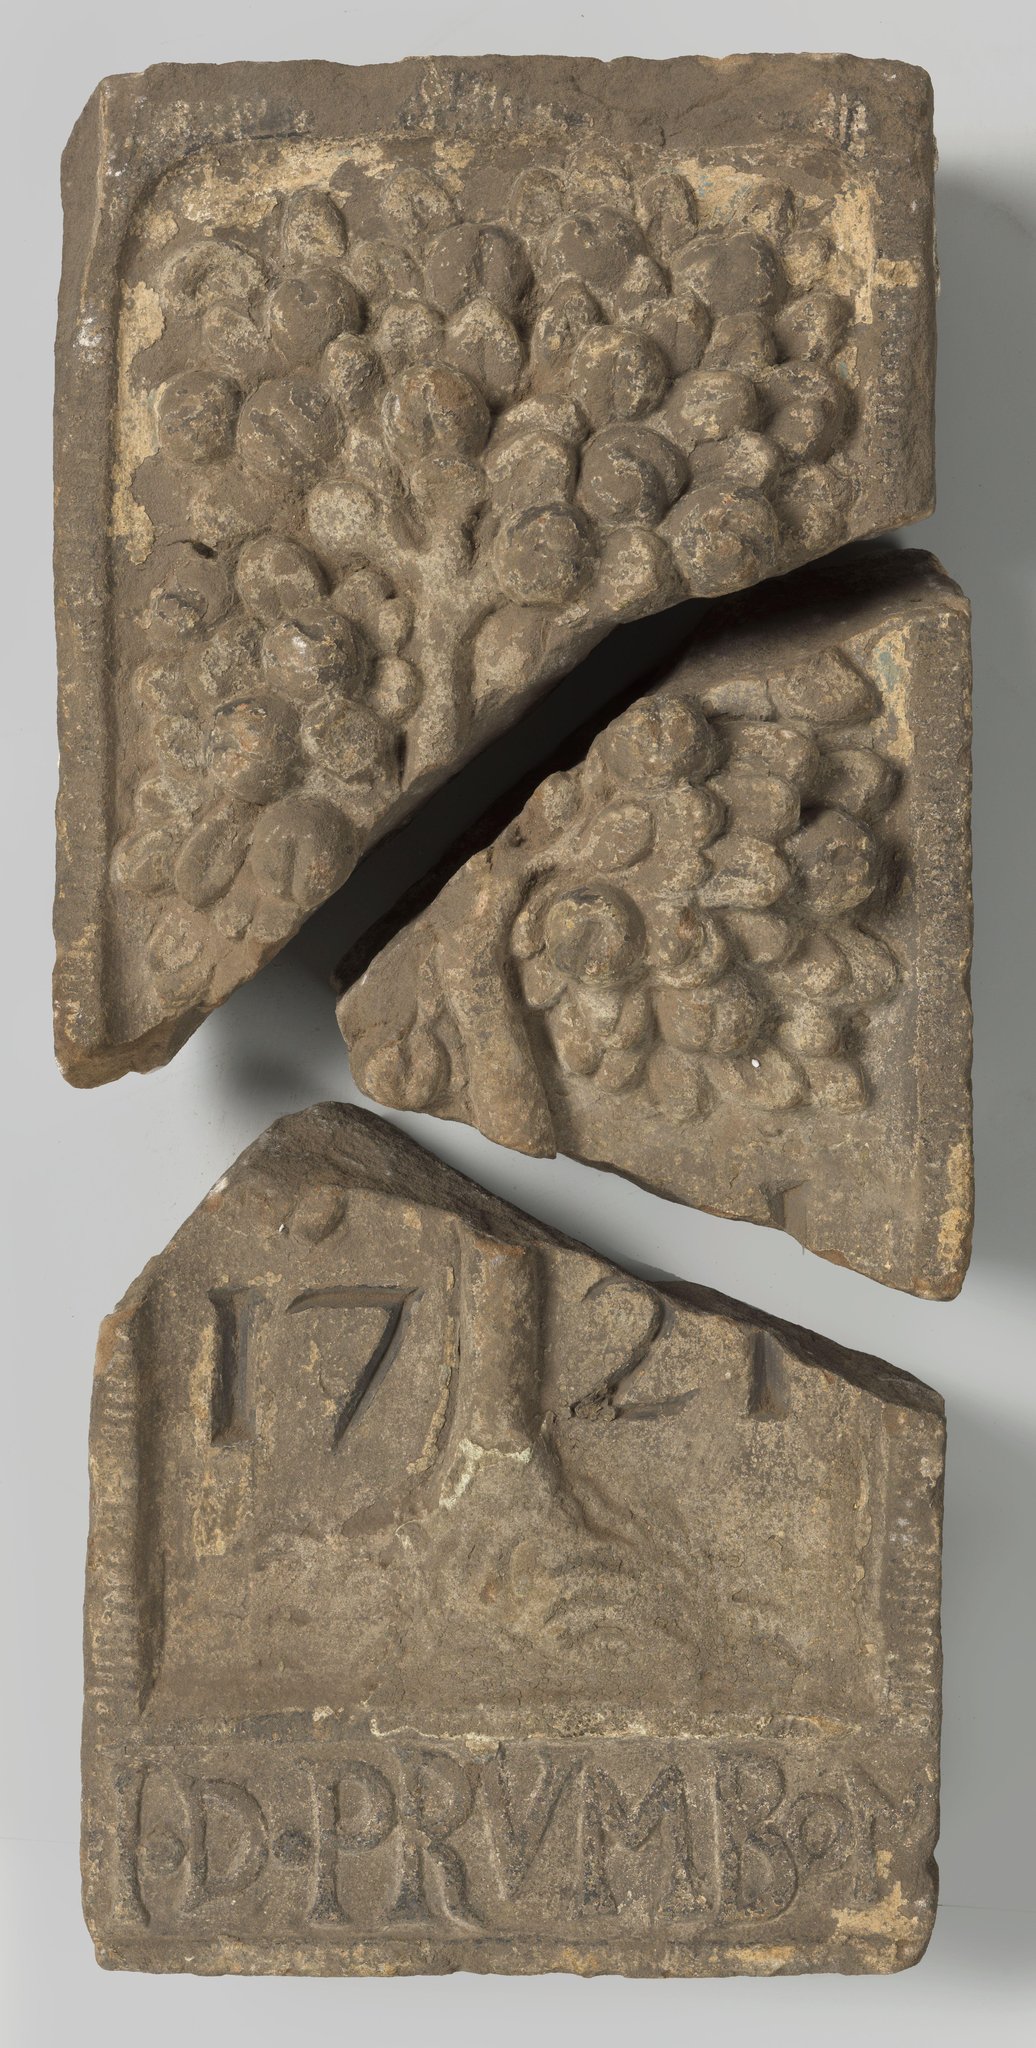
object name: gable stone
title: Gevelsteen met boom en opschrift: D.PRVMBOM.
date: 1721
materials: stone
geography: netherlands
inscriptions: date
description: Staande rechthoek met een boom met vruchten (pruimen). Links van de stam 17, rechts van de stam 21 en het onderschrift I.D. PRVMBOM. De gevelsteen is in drie stukken gebroken (KOG-ALS-1 t/m KOG-ALS-3).